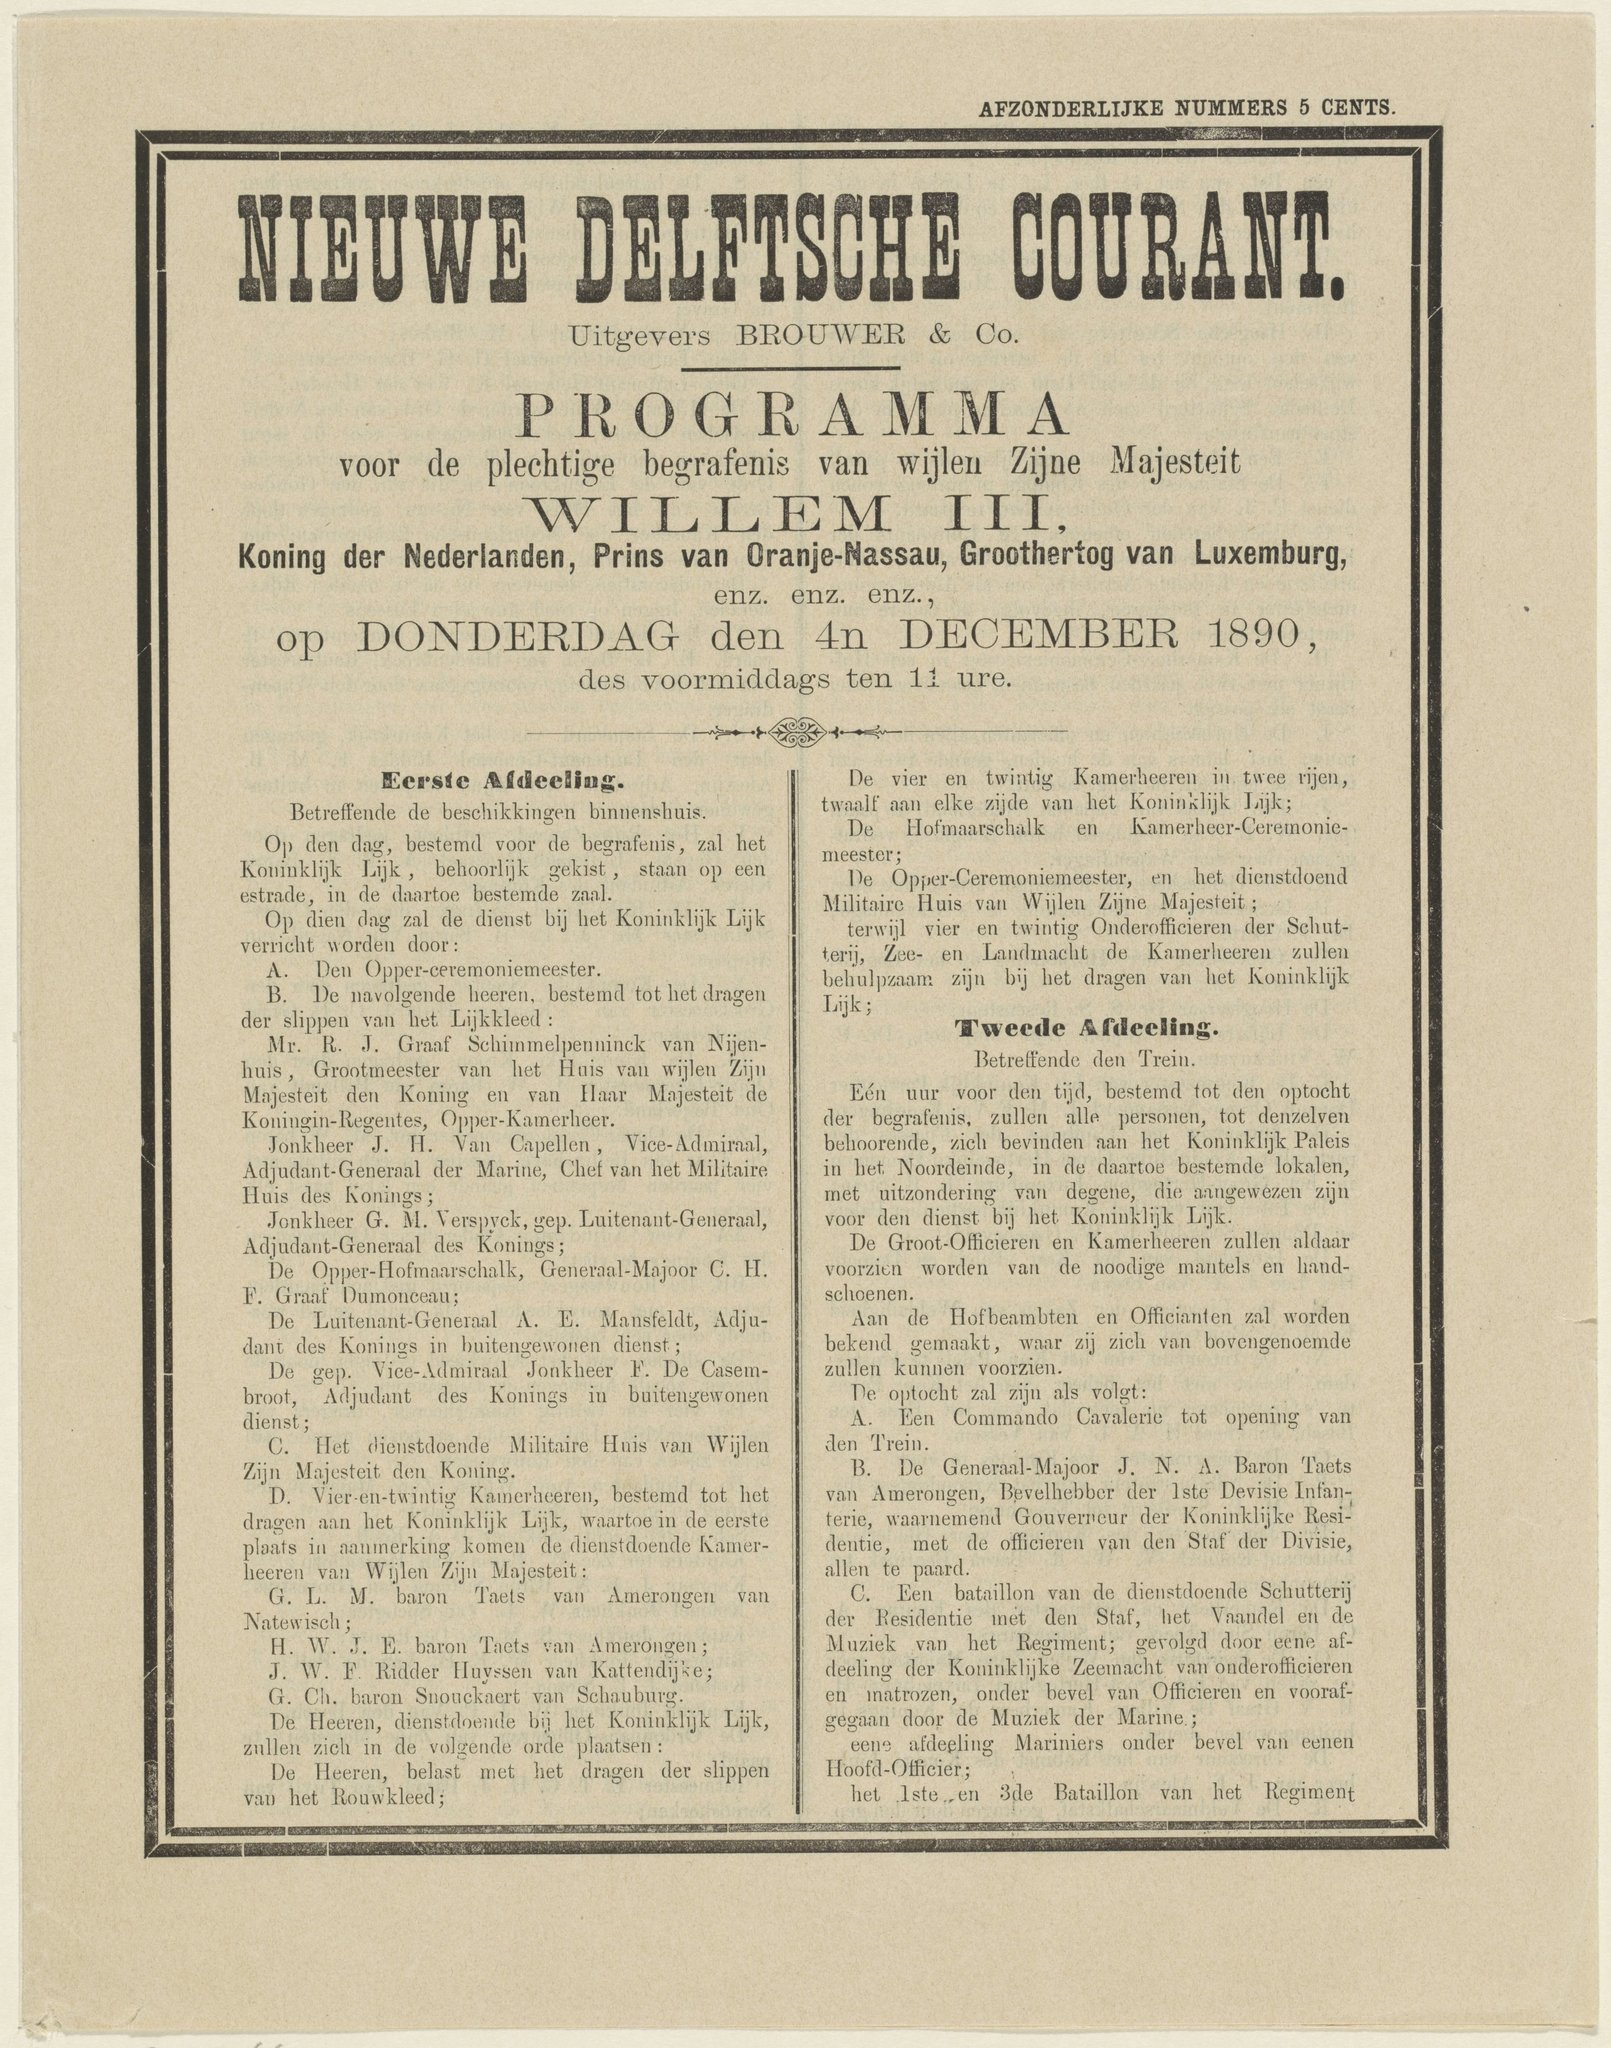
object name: newspaper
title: Nieuwe Delftsche Courant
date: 1890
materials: paper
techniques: letterpress printing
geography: delft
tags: brussels, willem iii (koning der nederlanden), funerary ceremonial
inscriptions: date